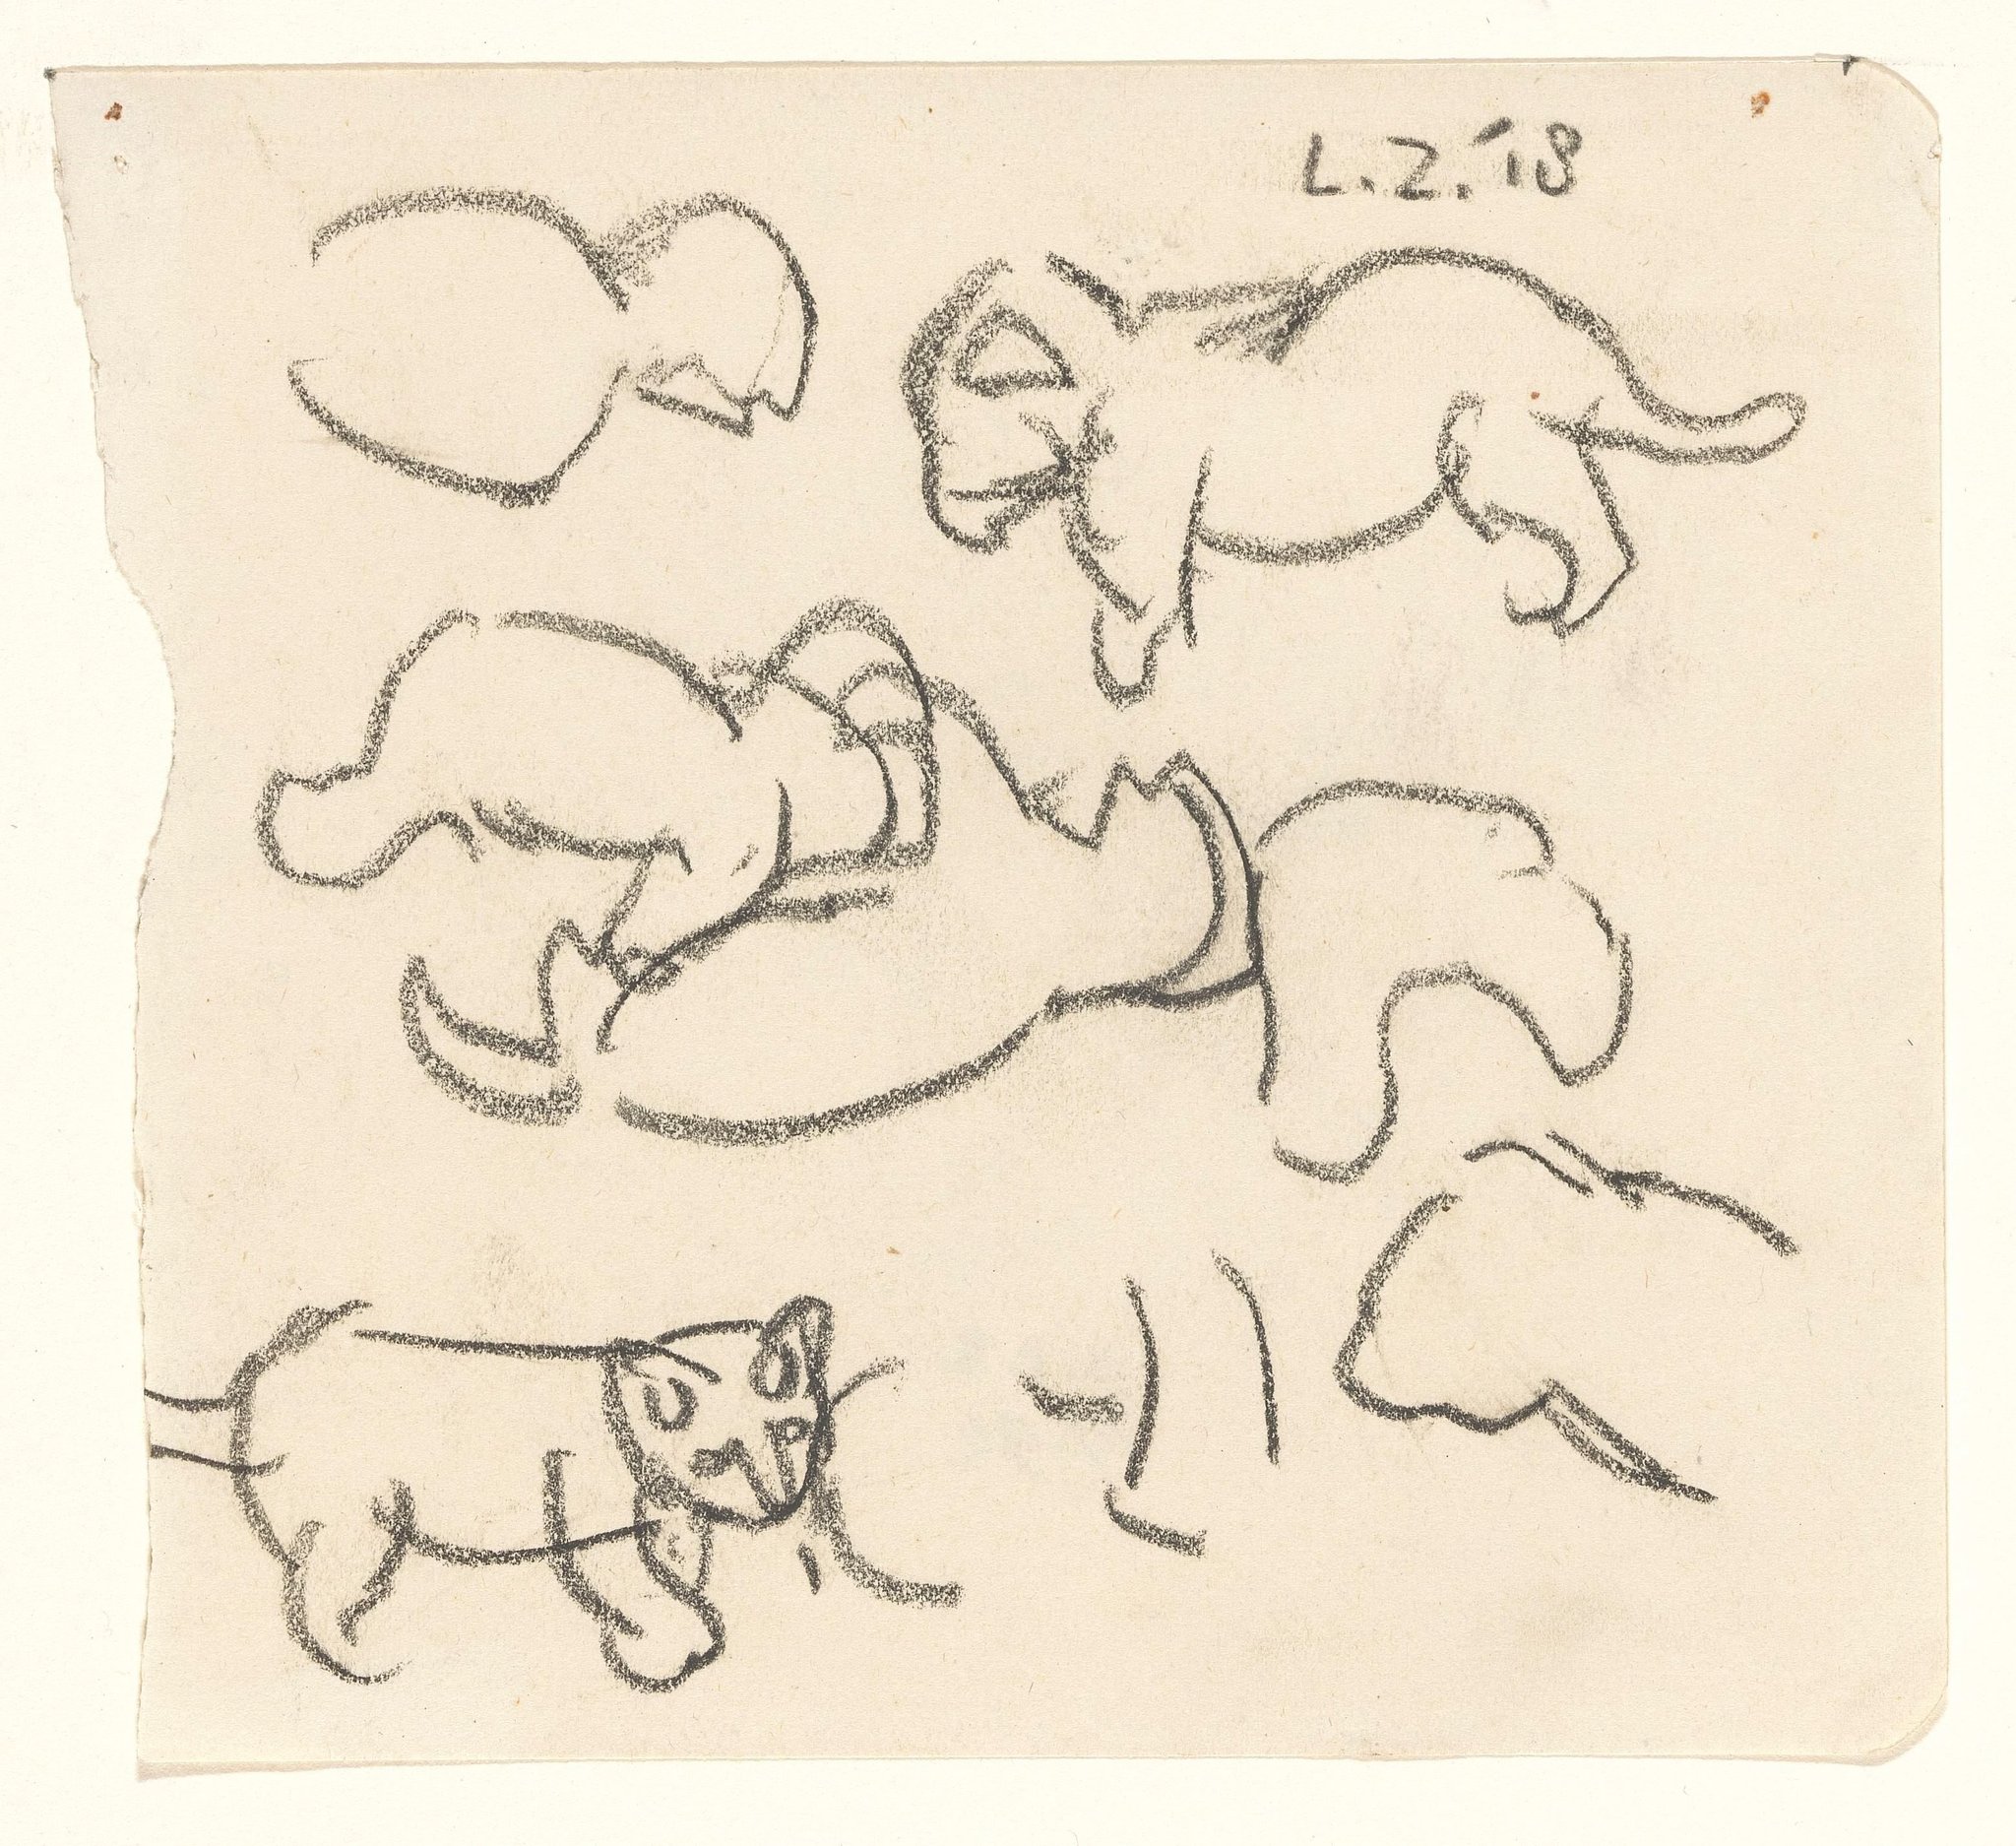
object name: drawing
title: Schetsen van een leeuwtje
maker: lambertus zijl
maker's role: designer, draughtsman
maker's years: 1866-1947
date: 1918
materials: chalk, paper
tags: beasts of prey, predatory animals: lion